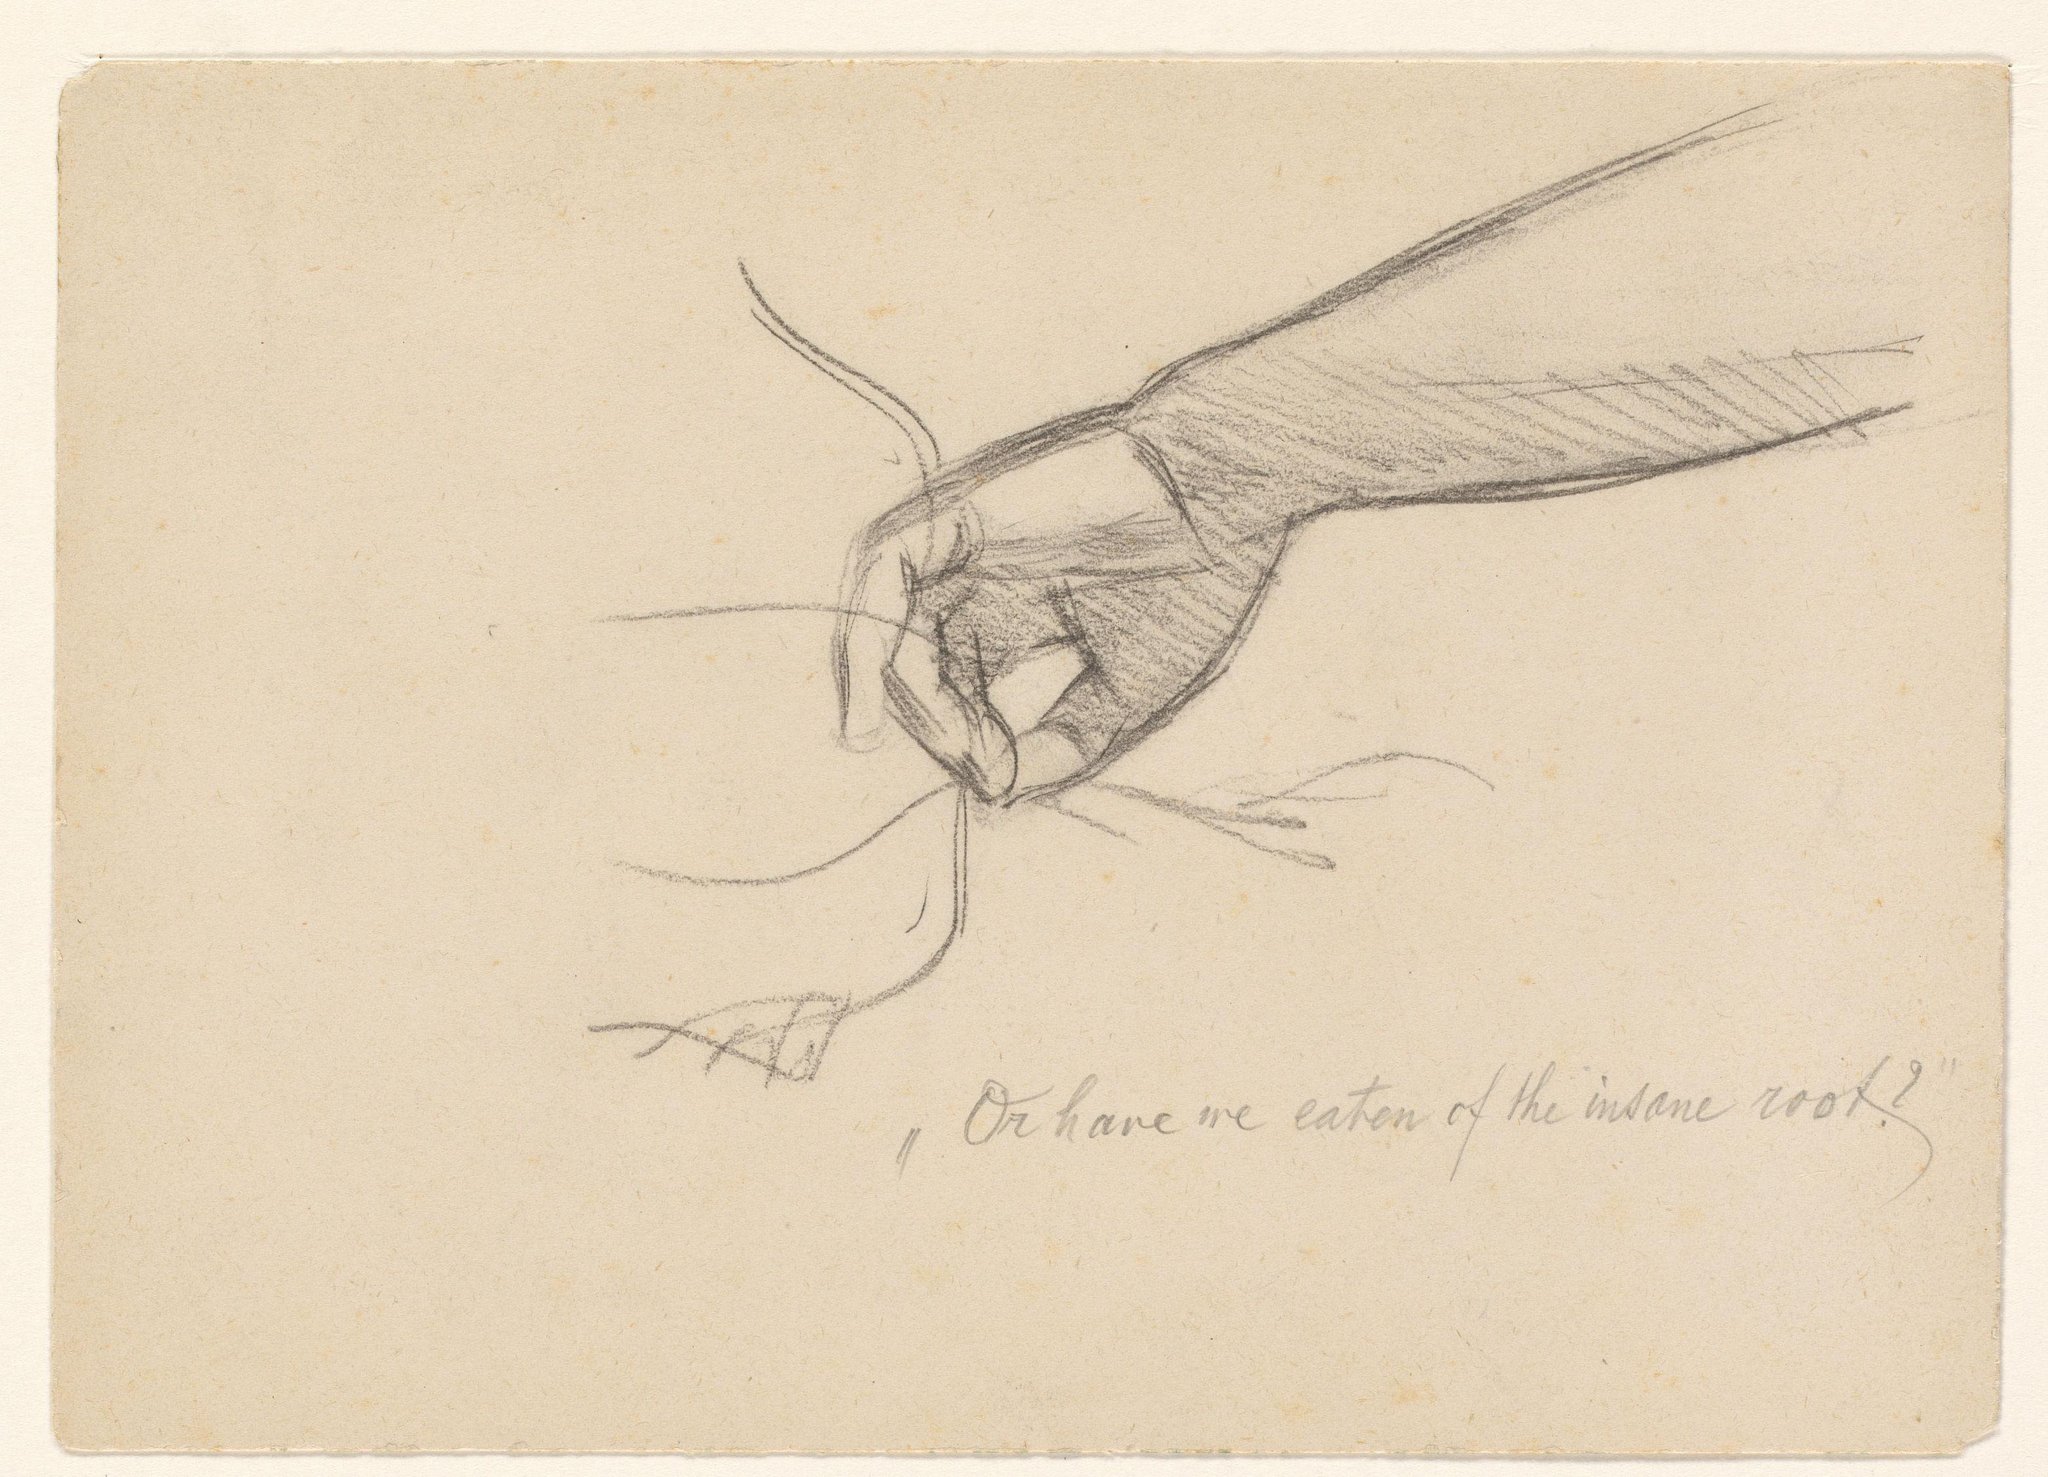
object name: drawing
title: Studie van een arm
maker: august allebé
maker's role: draughtsman, print maker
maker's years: 1838-1927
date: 1848-1927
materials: chalk, paper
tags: lying on one side, with uplifted upper part of the body and leaning on the arm